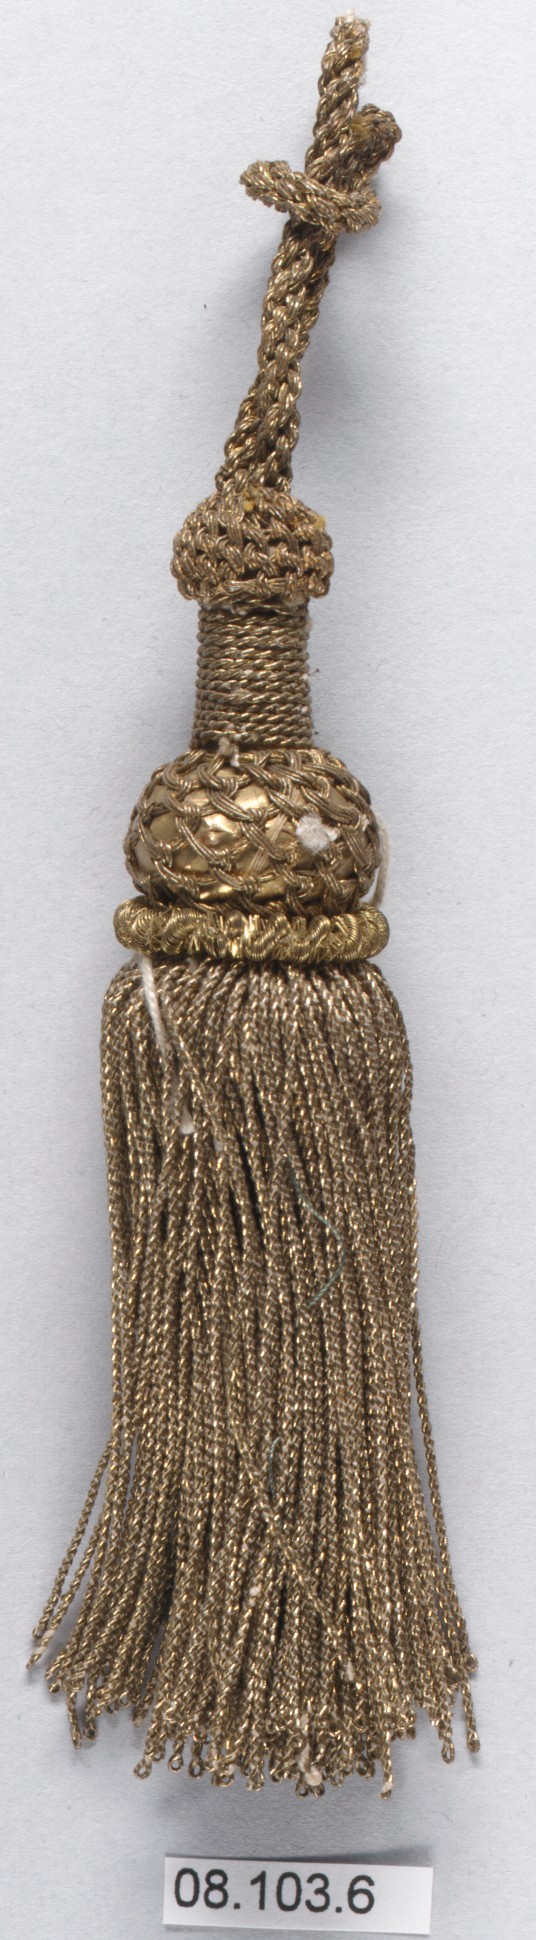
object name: tassel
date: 1701-1800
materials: metal thread